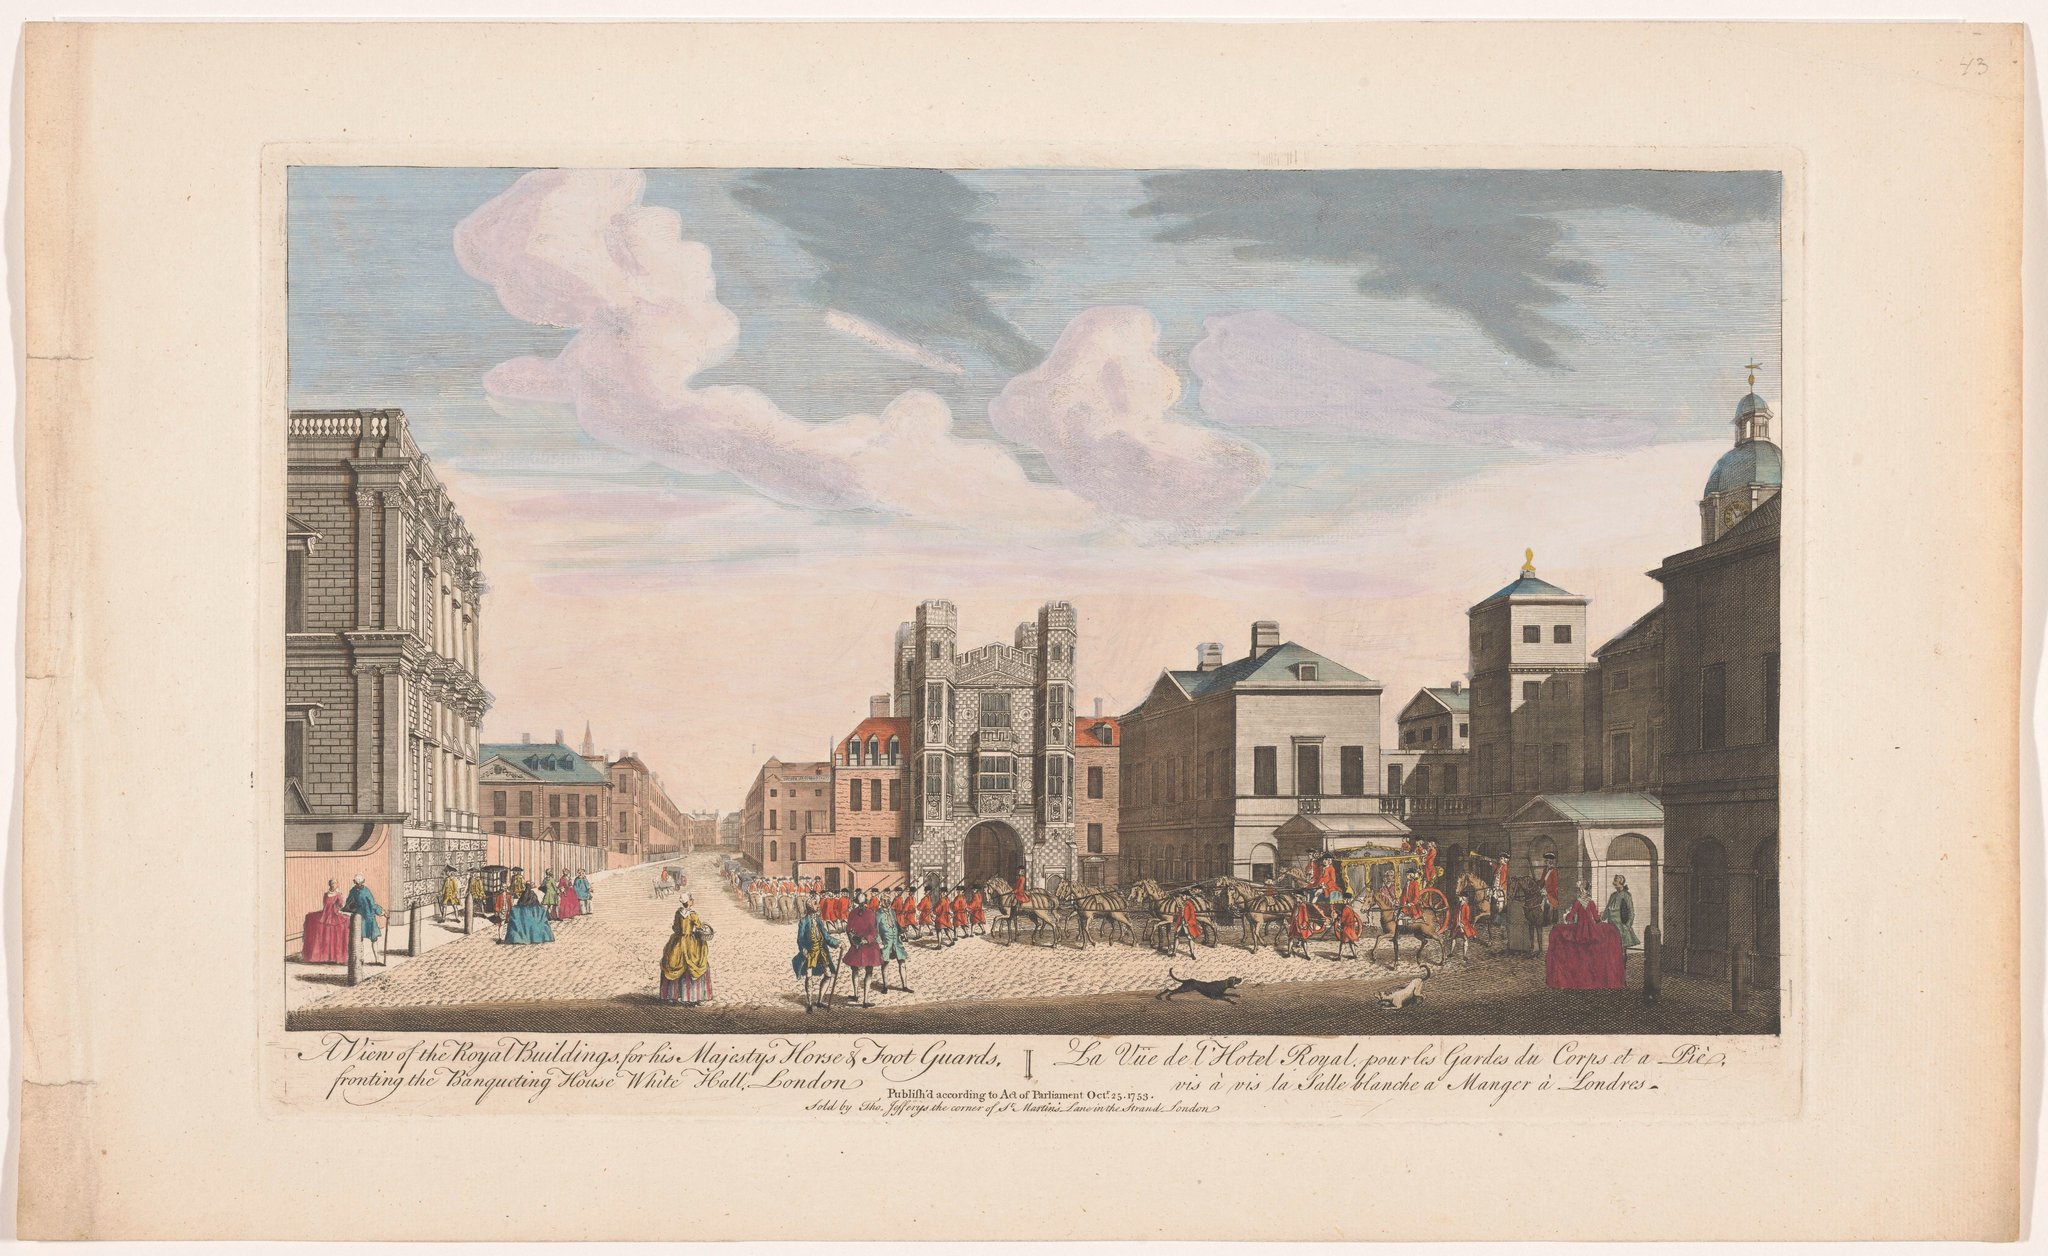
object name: opticaprent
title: A view of the royal buildings, for His Majestys horse & foot guards, fronting the Banqueting House White Hall, London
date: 1753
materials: paper, watercolor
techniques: brush, etching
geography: england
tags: palace, civic architecture; edifices; dwellings, guard duty, keeping sentry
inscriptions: watermark